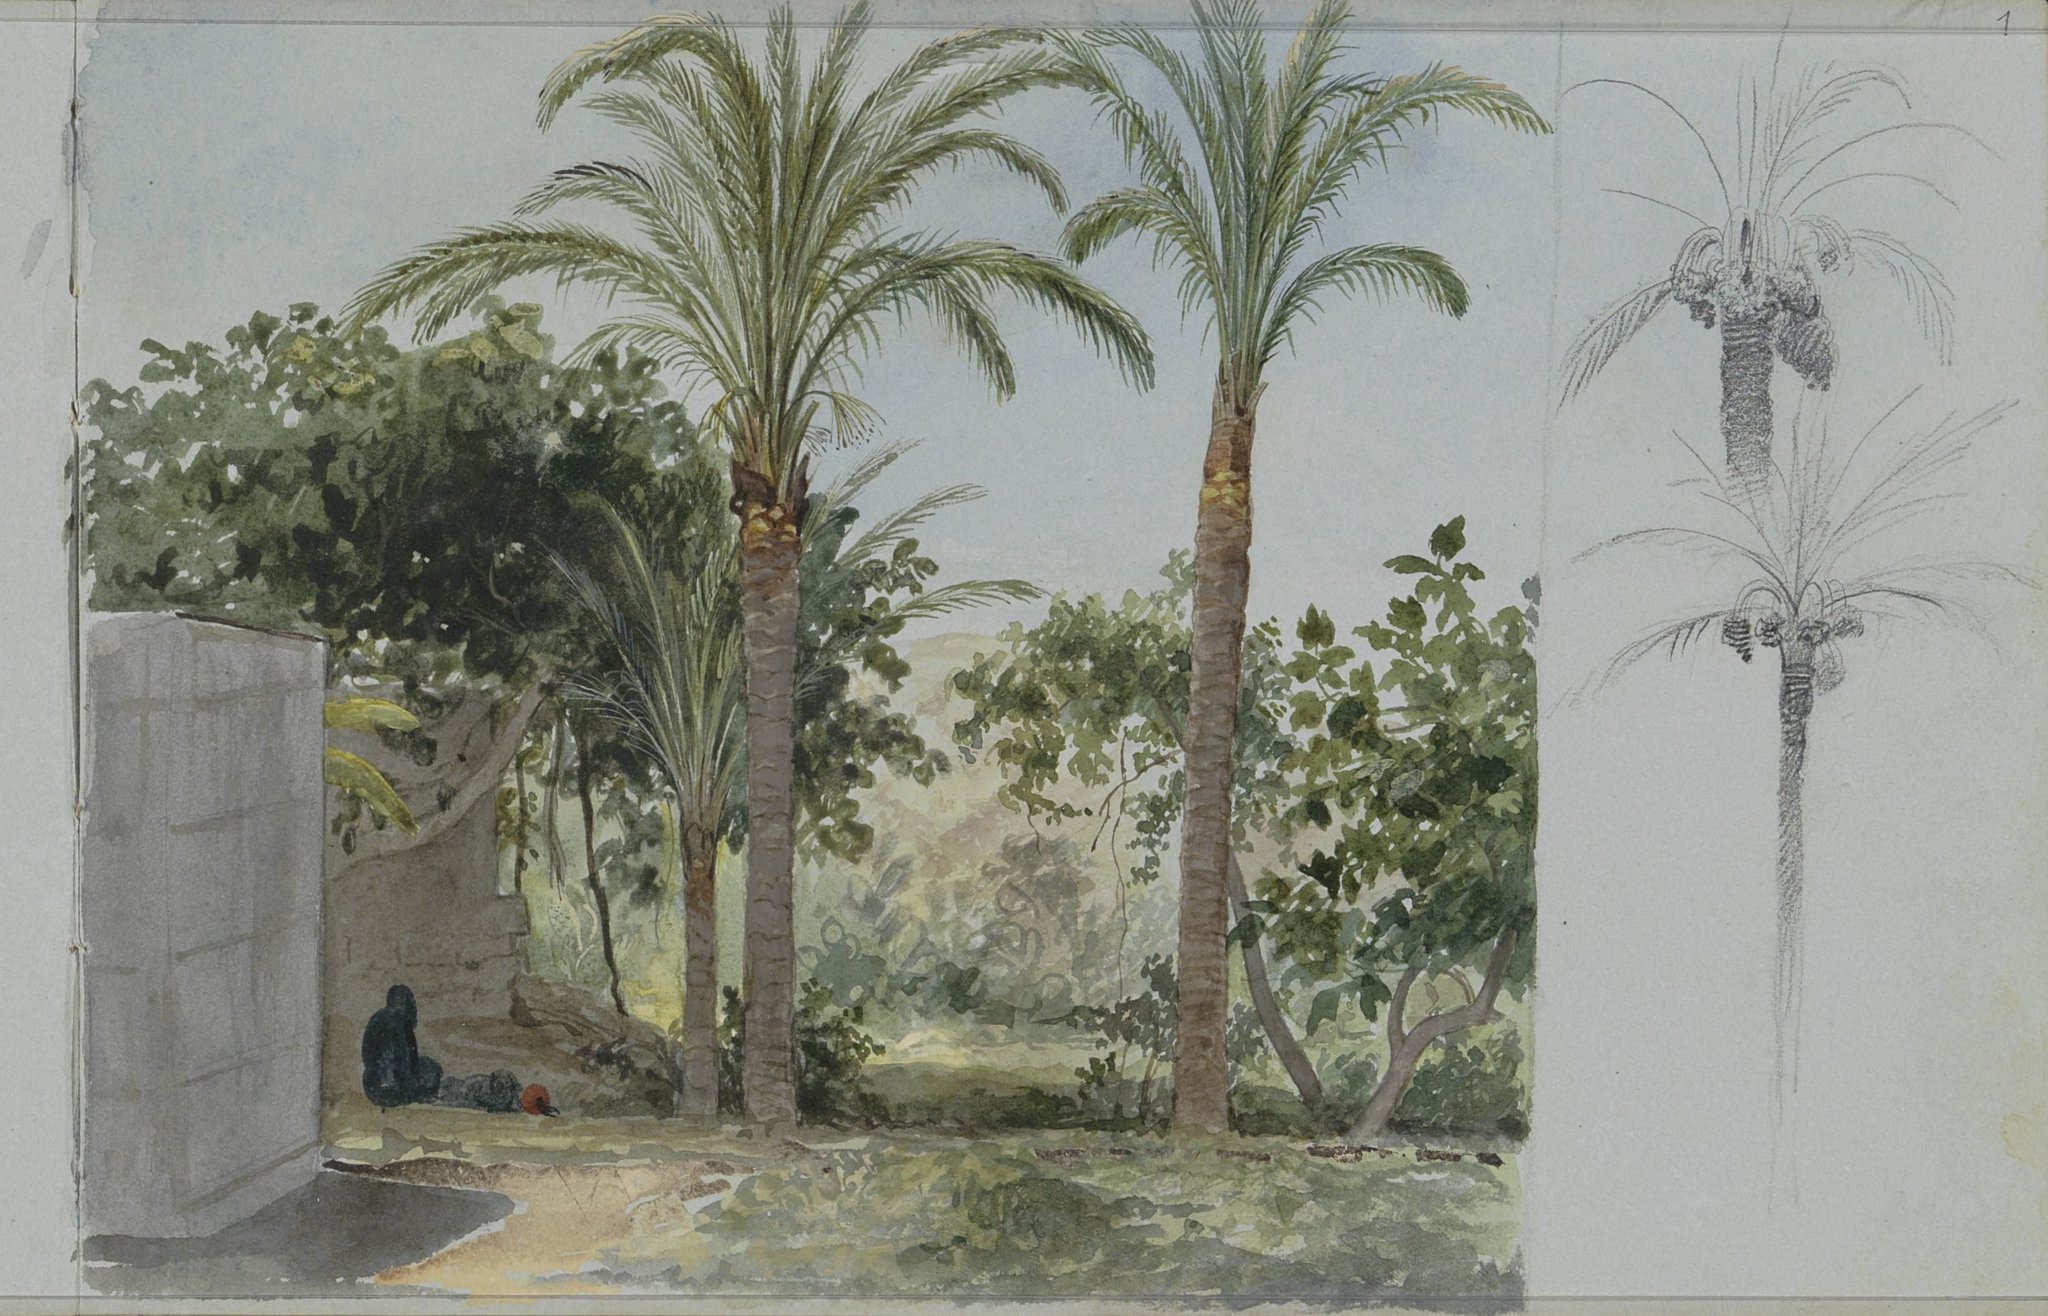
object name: sketchbook leaf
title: Oase met palmbomen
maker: willem de famars testas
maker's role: draughtsman, painter, print maker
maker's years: 1834-1896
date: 1858-1860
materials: paper, pencil, watercolor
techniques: brush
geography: egypt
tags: oasis, trees: palm-tree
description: Tevens studies van palmbomen. Blad 1 recto uit een schetsboek met 23 bladen.